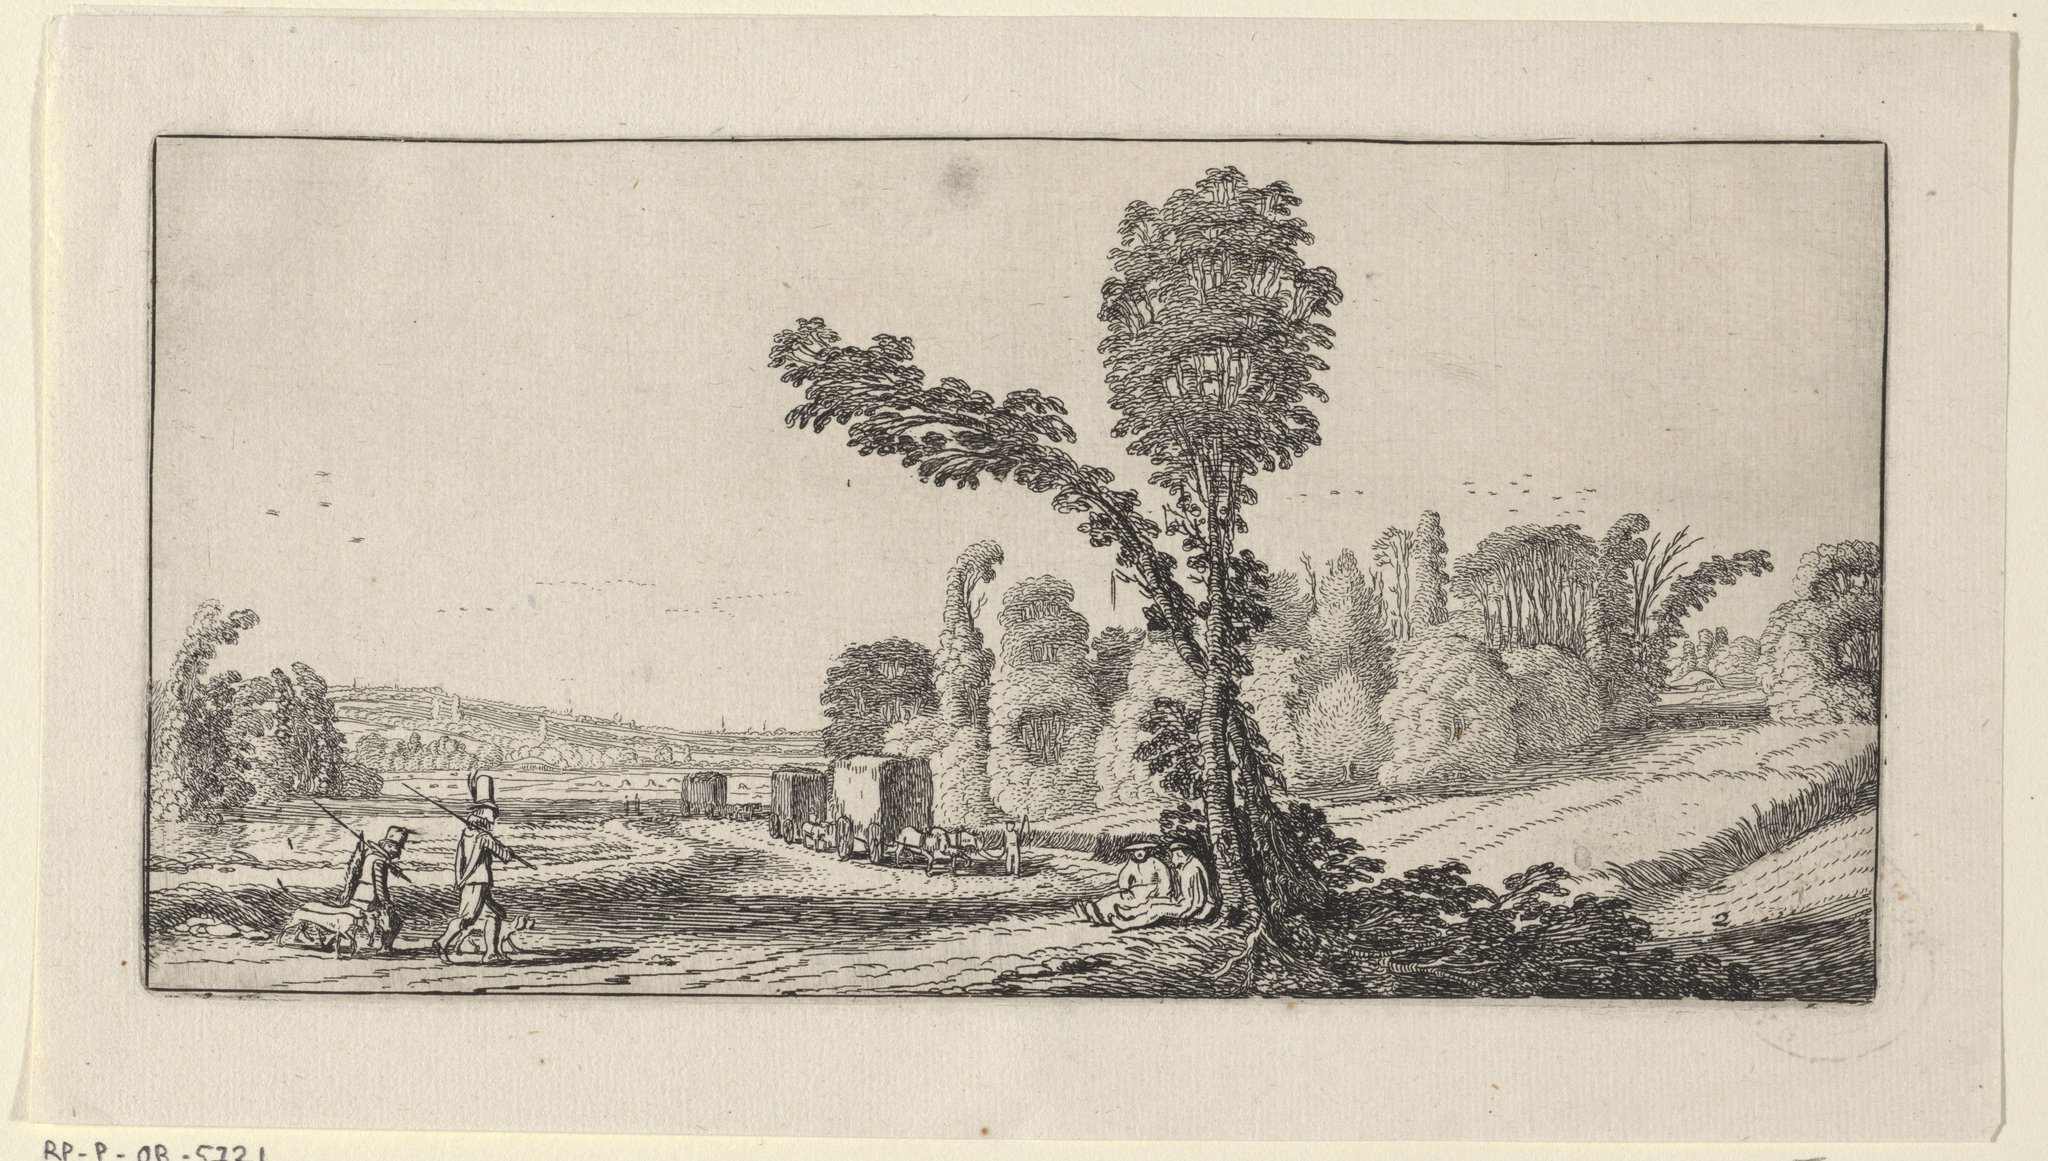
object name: print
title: Landschap met jagers en hooiwagens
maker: jan van de velde (ii)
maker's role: draughtsman, painter, print maker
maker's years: 1593-1641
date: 1603-1641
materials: paper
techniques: etching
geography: northern netherlands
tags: trees, (traveller) resting in the open air, hay-wagon, return from the hunt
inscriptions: collector's mark: Lugt 240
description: Landschap met jagers met honden en hooiwagens op een landweg. Twee rustende figuren onder een boom. Tweede prent uit een serie van zes.